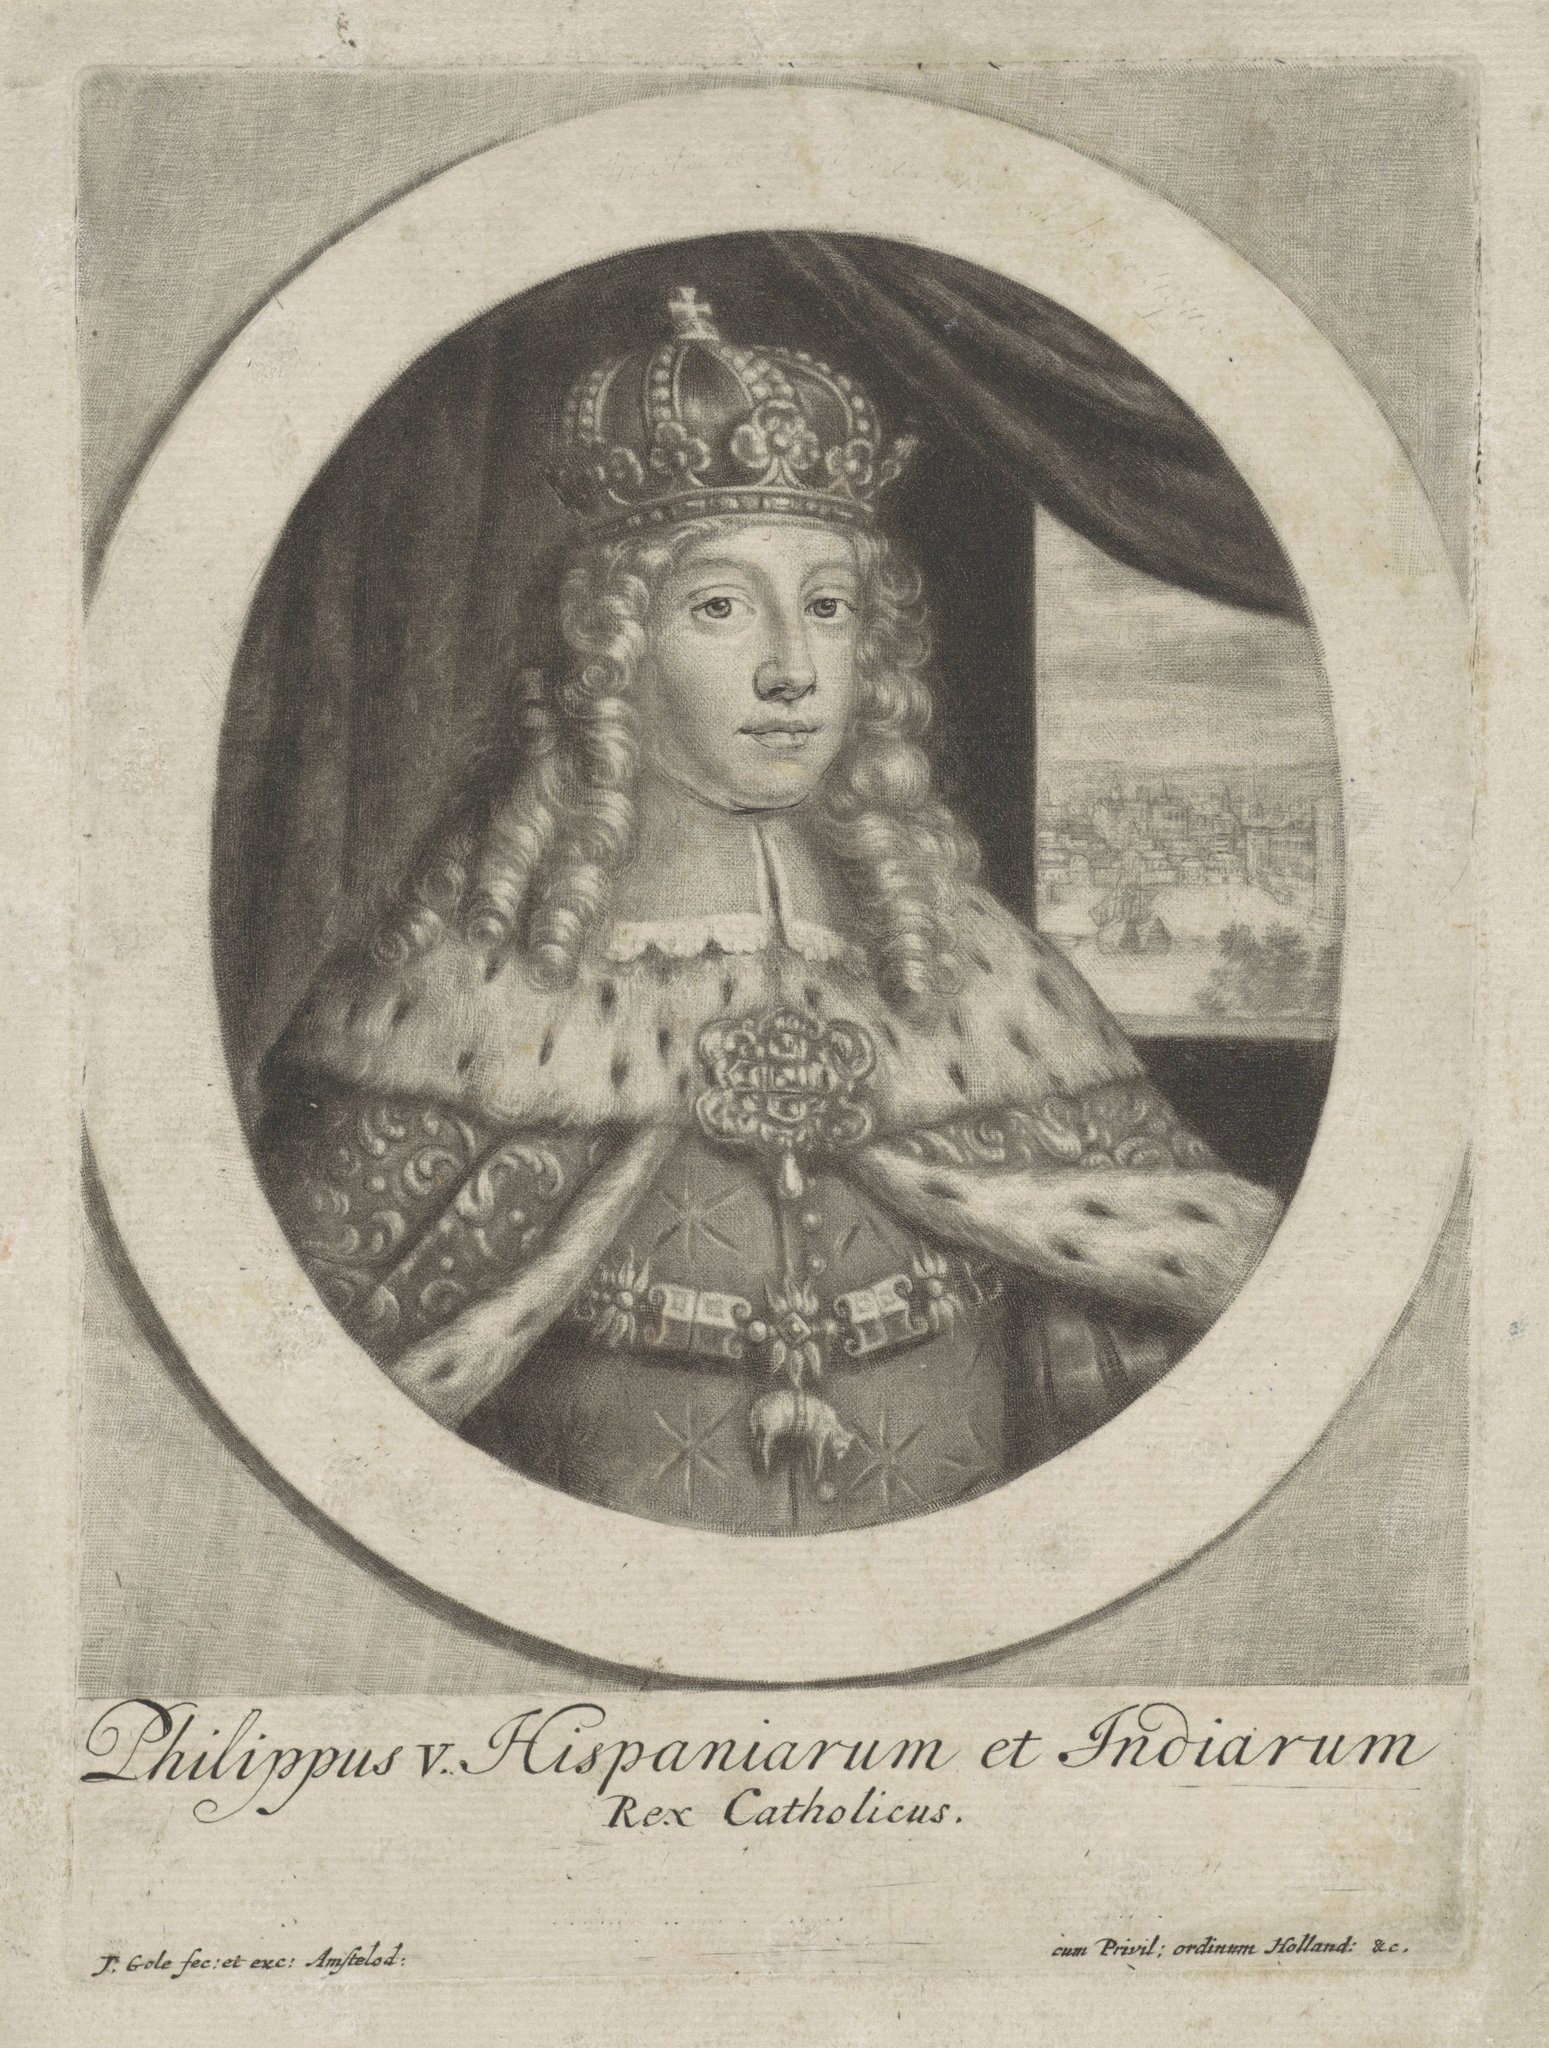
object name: print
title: Portret van Filips V, koning van Spanje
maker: jacob gole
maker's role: print maker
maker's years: 1660-1724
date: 1700-1724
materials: paper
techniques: engraving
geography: amsterdam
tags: filips v (koning van spanje), crown (symbol of sovereignty), knighthood order of the golden fleece, mantle, gown, dress (symbol of sovereignty)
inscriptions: collector's mark: Lugt 2228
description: De jonge hertog Filips van Anjou, vanaf 1700 koning Filips V van Spanje. Hij draagt een kroon, de kroningsmantel en een keten met het ordeteken van de Orde van het Gulden Vlies.